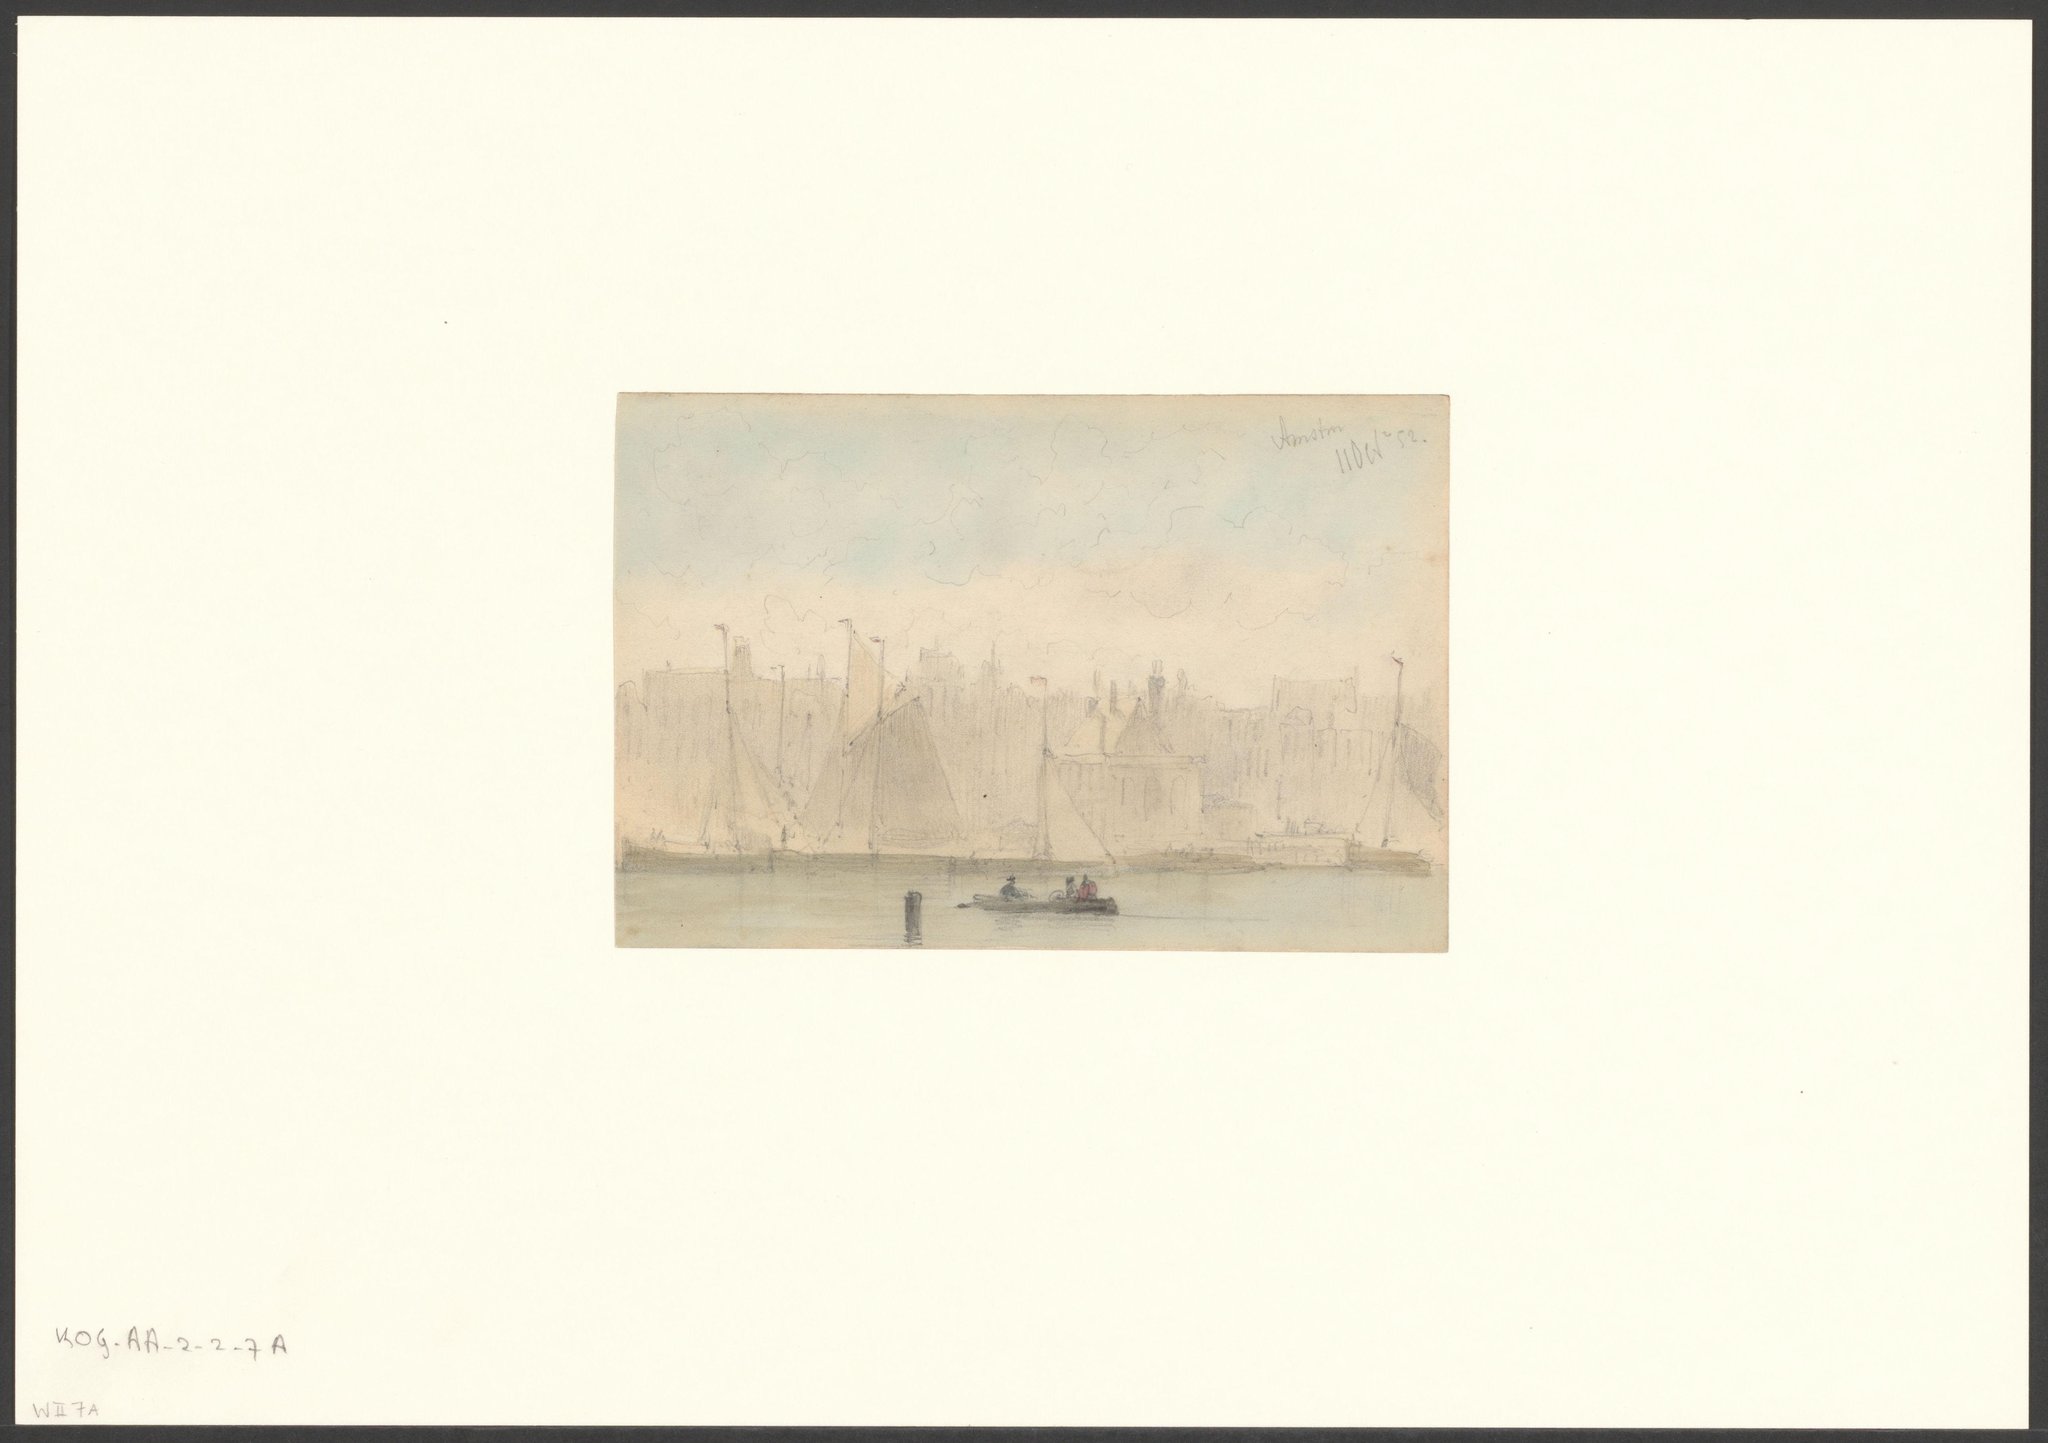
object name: drawing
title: Gezicht op het Kamperhoofd en het Zeerecht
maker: everhardus koster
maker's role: draughtsman, painter, print maker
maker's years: 1817-1892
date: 1852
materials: paper, pencil, watercolor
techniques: brush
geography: amsterdam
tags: sailing-ship, sailing-boat, city-view in general; 'veduta', river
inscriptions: date and inscription: ‘Amstm / 11 Oct 52.’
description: Tekening binnen de Atlas Van Eck ingedeeld op wijknummer 2.